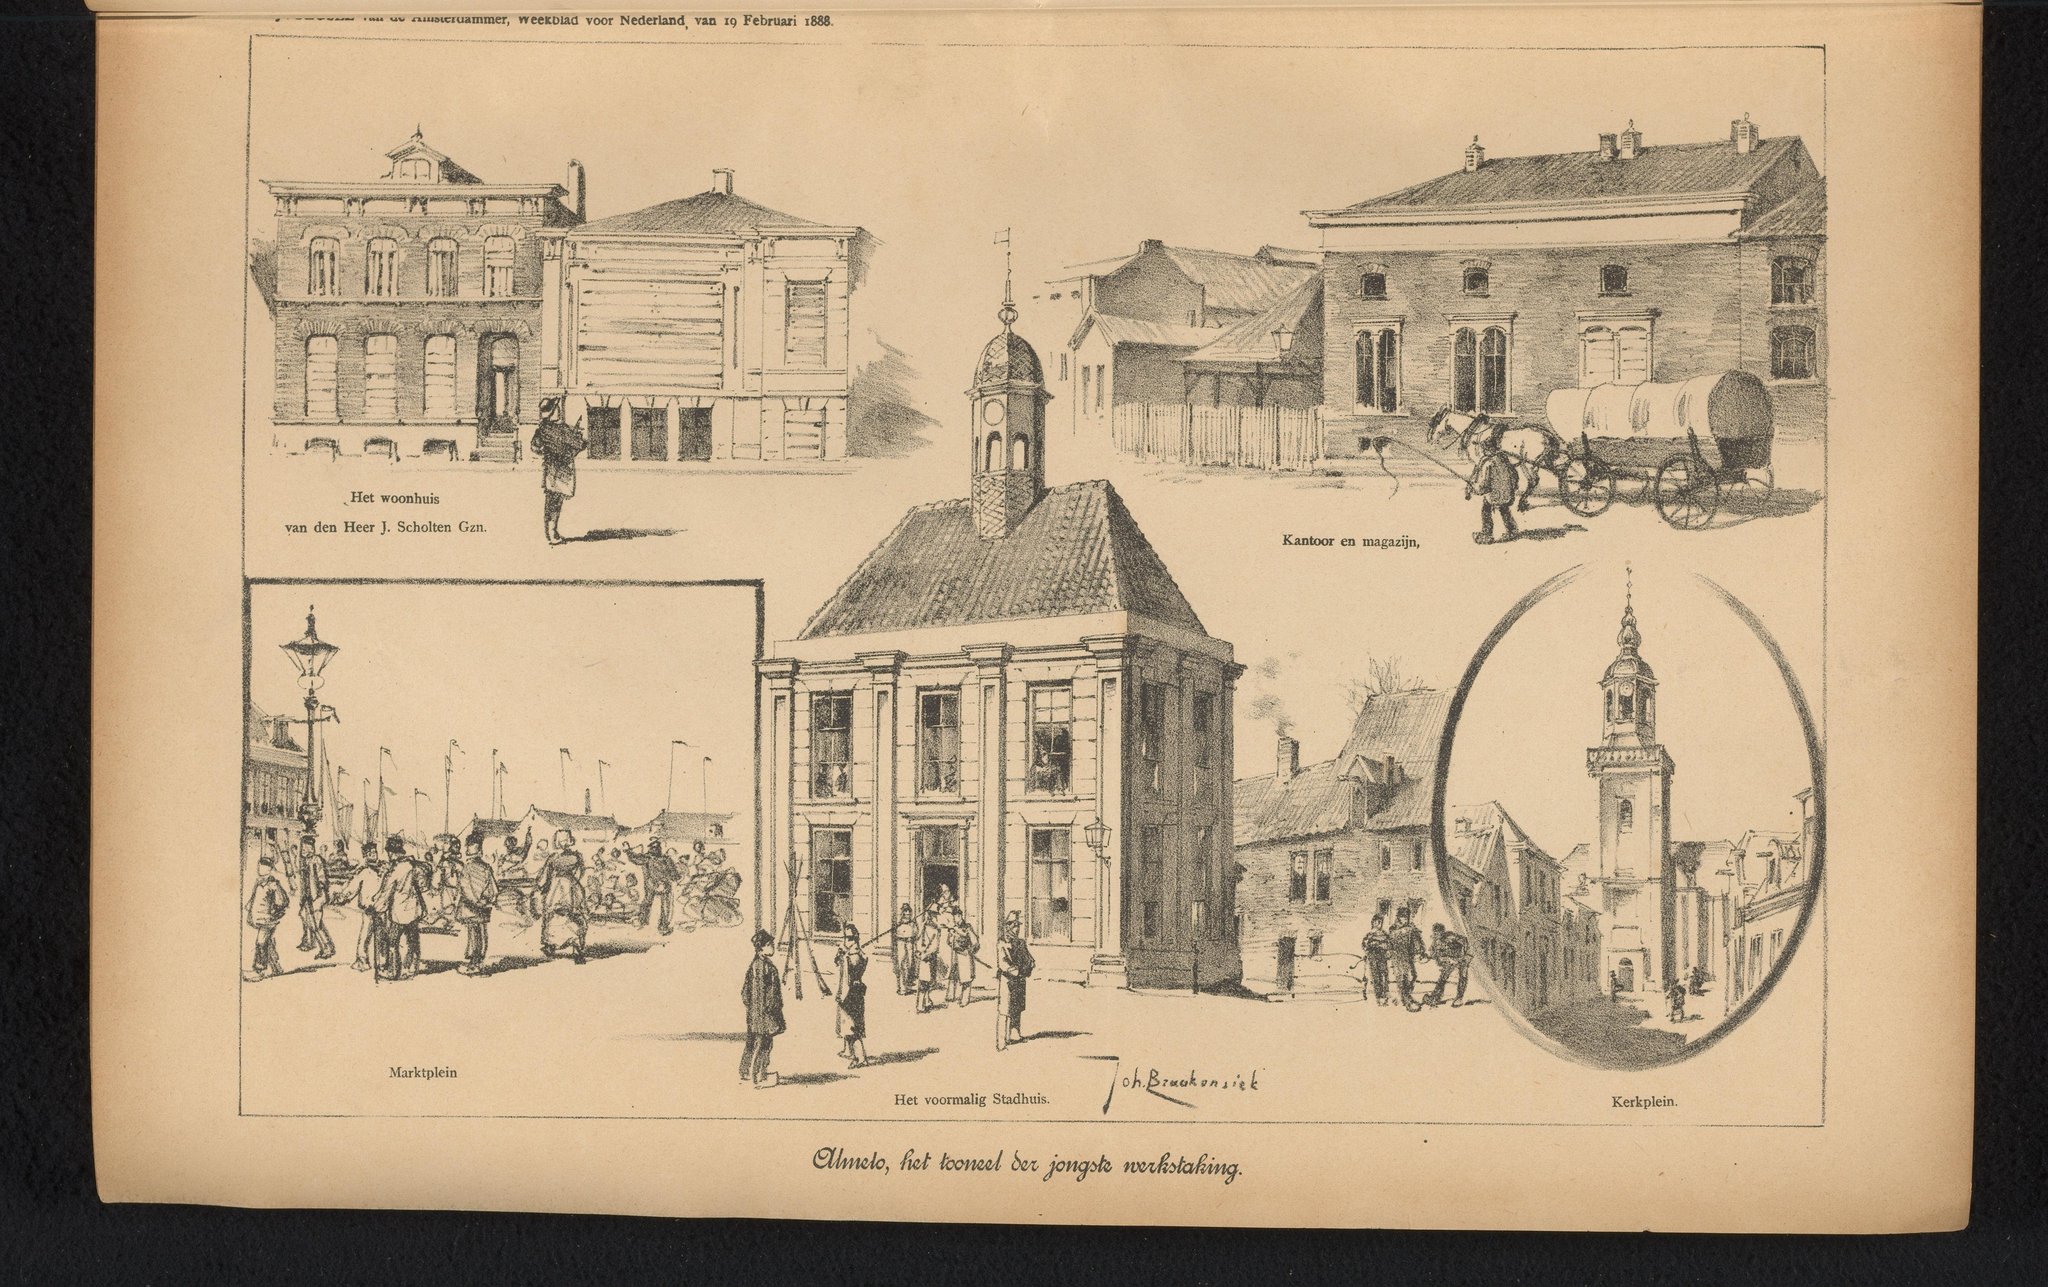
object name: print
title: Almelo, het tooneel der jongste werkstaking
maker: johan braakensiek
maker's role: draughtsman, print maker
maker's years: 1858-1940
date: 1888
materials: paper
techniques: lithograph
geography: amsterdam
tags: city-view in general; 'veduta', strike (political demonstration)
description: Vijf gezichten in de stad Almelo, waar een staking plaatsvindt: het woonhuis van dhr. J. Scholten Gzn., een kantoor met magazijn, het Marktplein, het voormalig stadhuis en het Kerkplein.